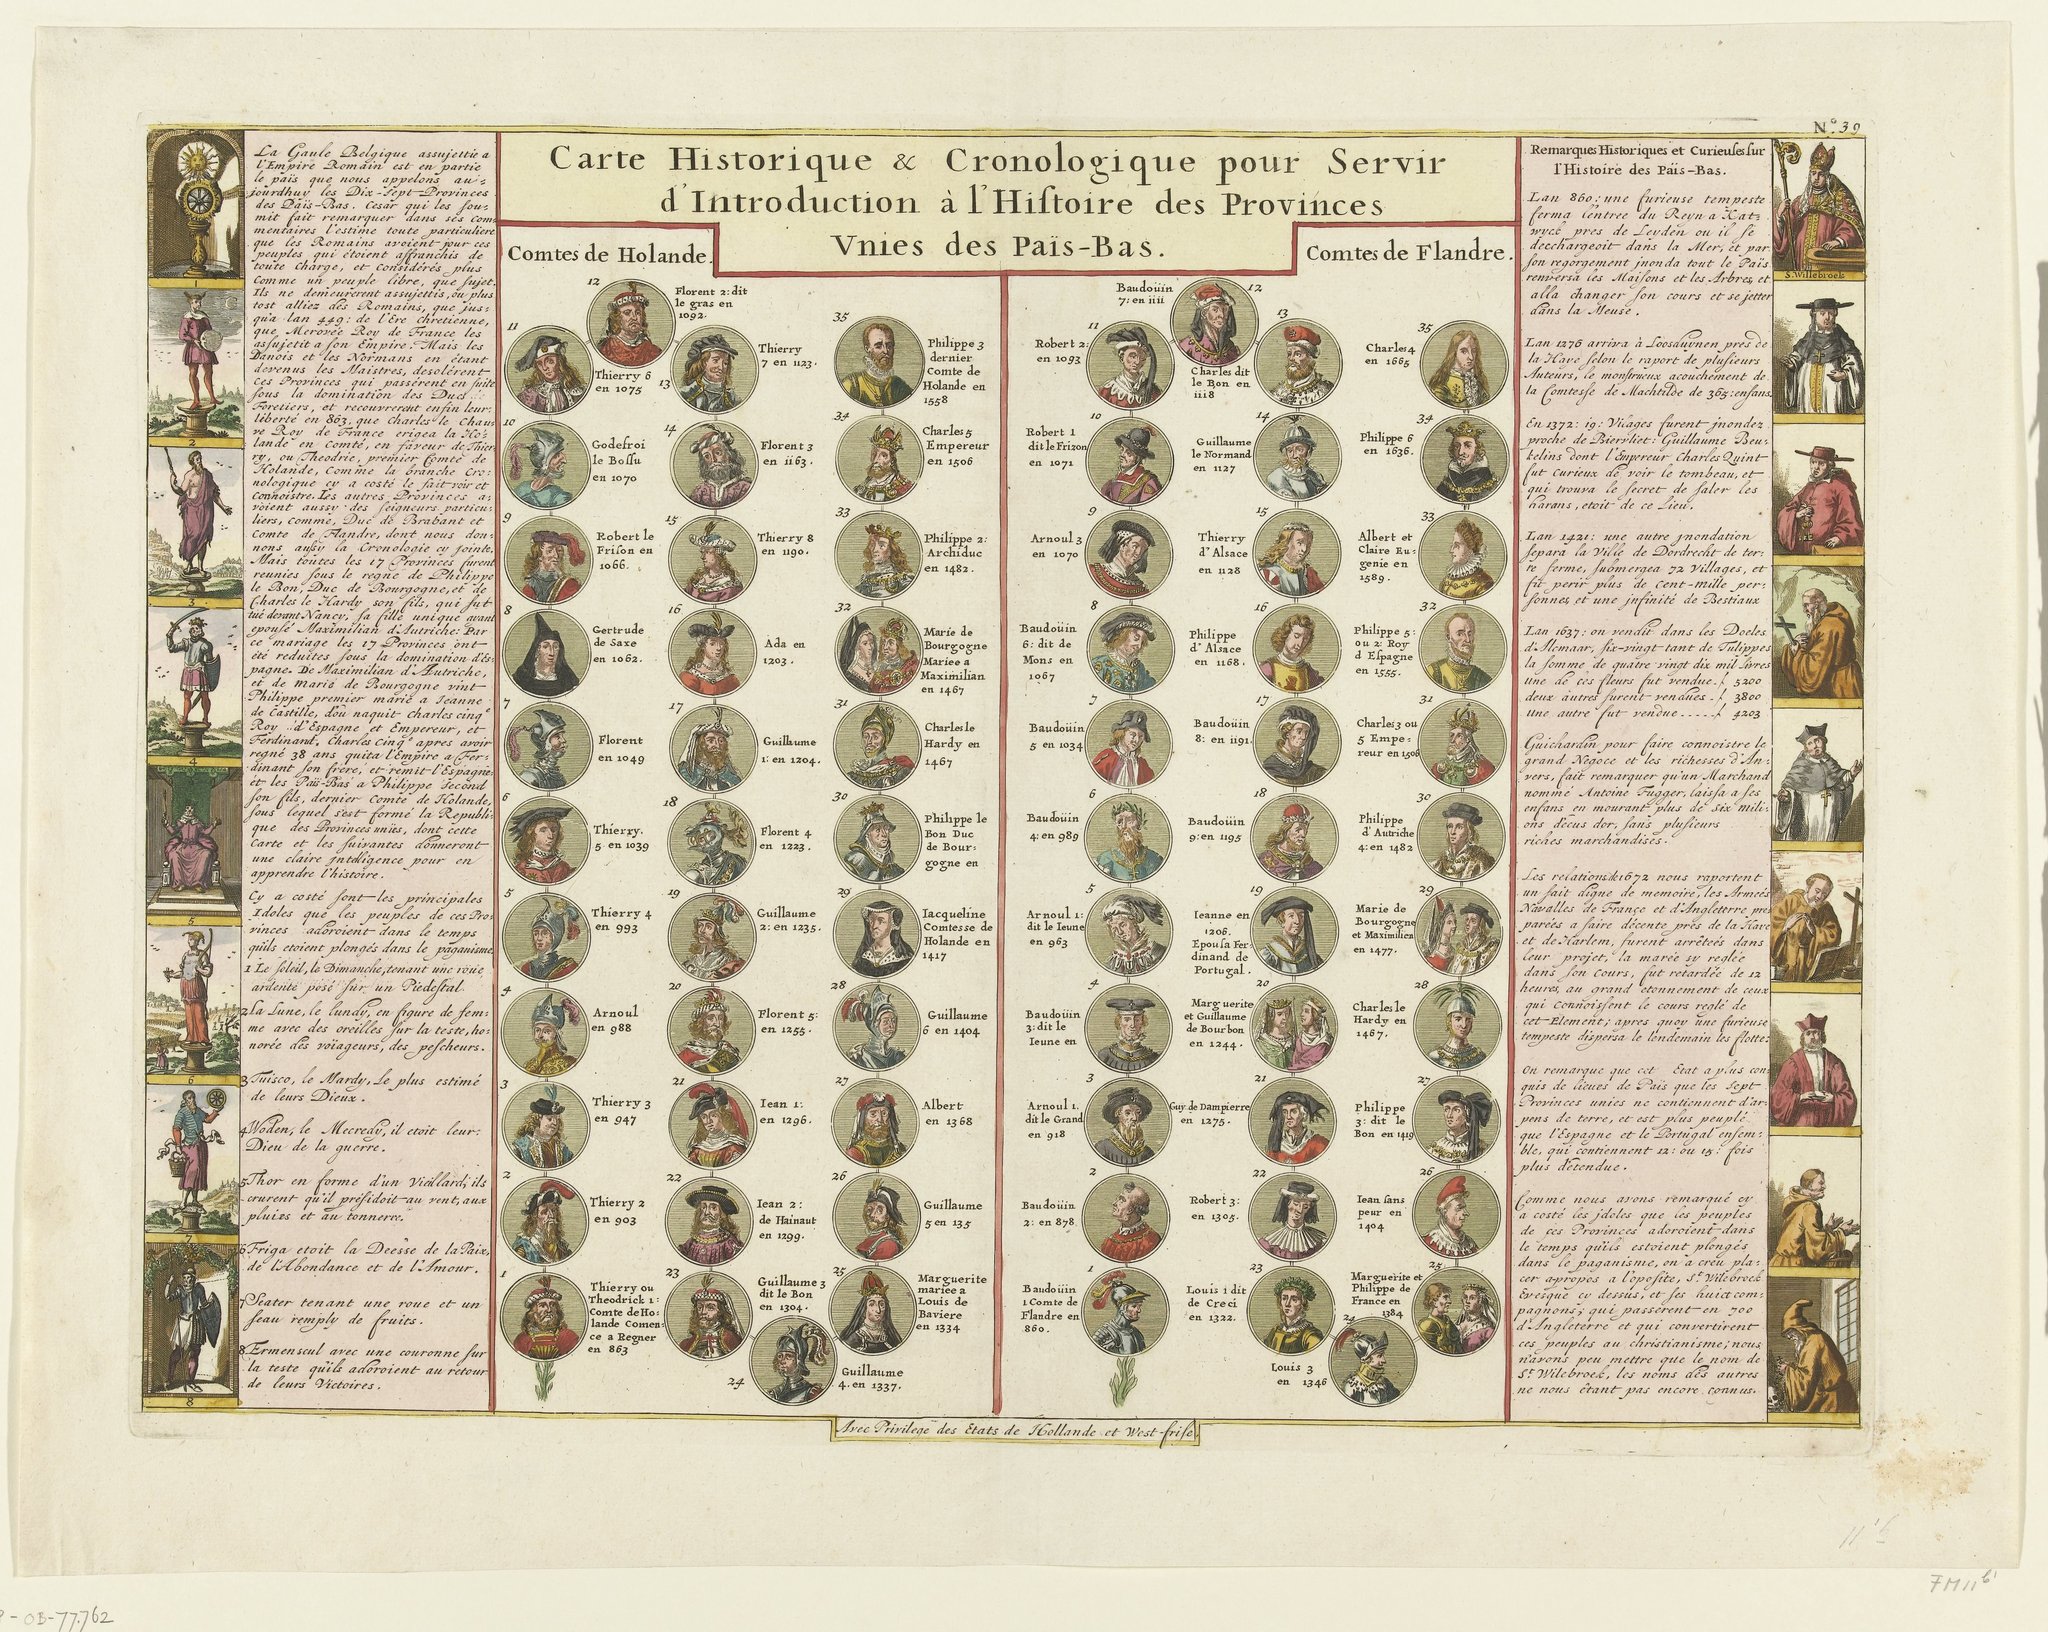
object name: print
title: Carte Historique & Cronologique pour Servir d'Introduction à l'Histoire des Provinces Unies des Païs-Bas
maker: Anonymous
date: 1700-1701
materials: paper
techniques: etching, hand coloring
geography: netherlands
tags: netherlands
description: Overzichtsblad met in kleine medaillons de ingekleurde portretten van de graven van Holland en de graven van Vlaanderen. Plaat 39 uit Histoire abregée des Provinces-Unies des Païs-Bas, 1701.